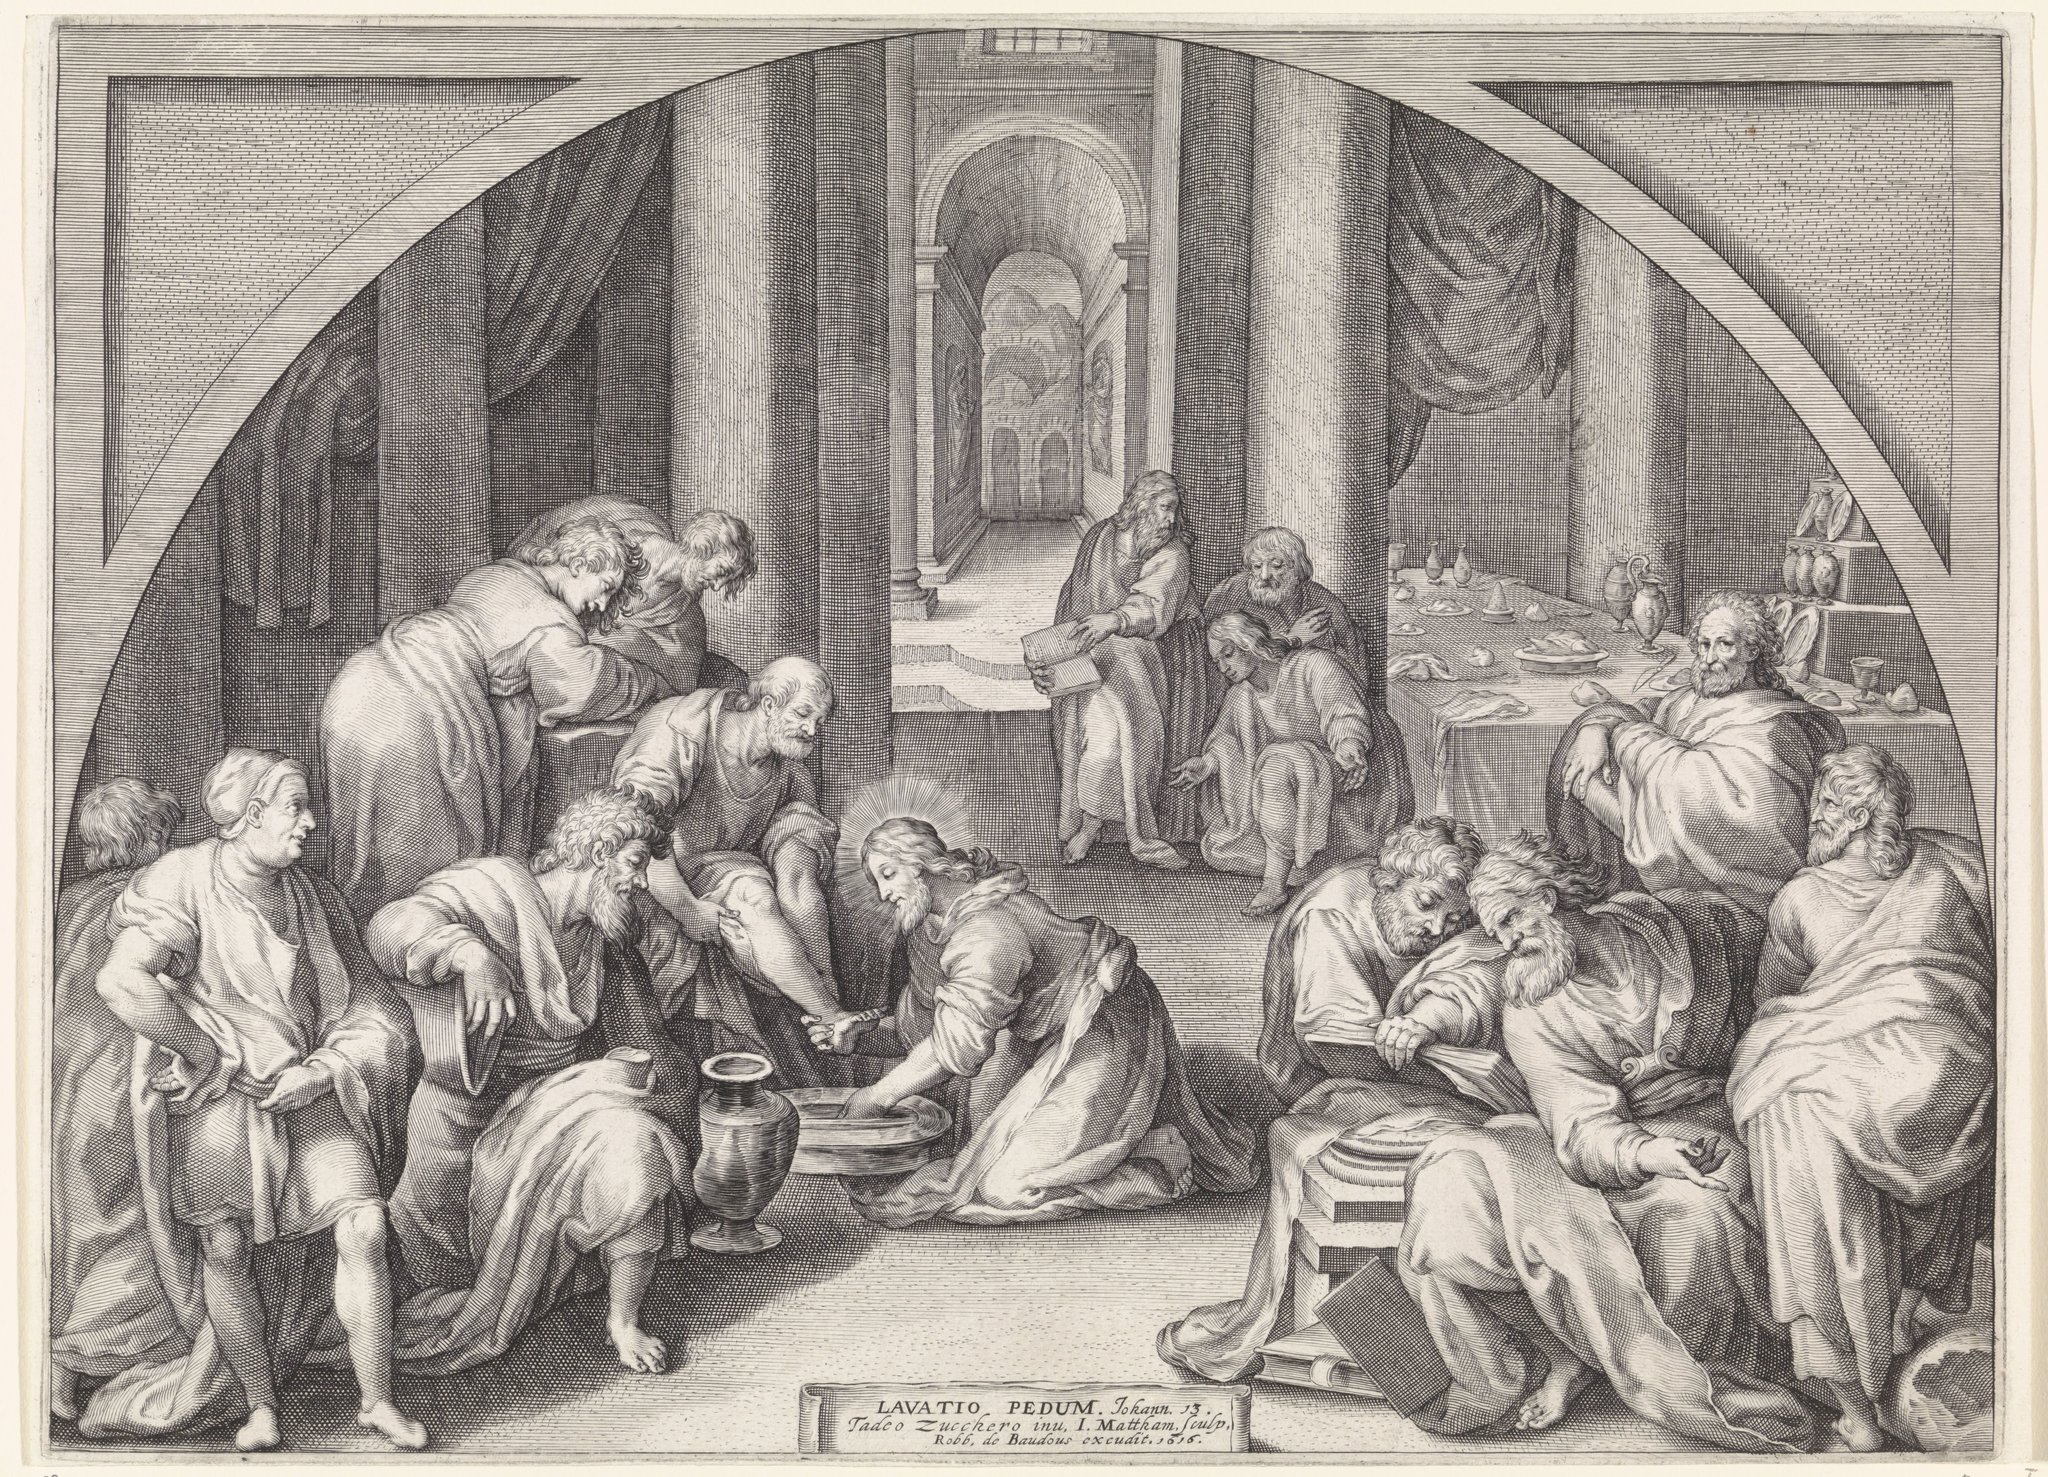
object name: print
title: Voetwassing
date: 1616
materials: paper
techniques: engraving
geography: haarlem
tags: christ washes the feet of the apostles (john 13:1-20)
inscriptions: collector's mark: Lugt 240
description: Christus wast de voeten van de apostelen.